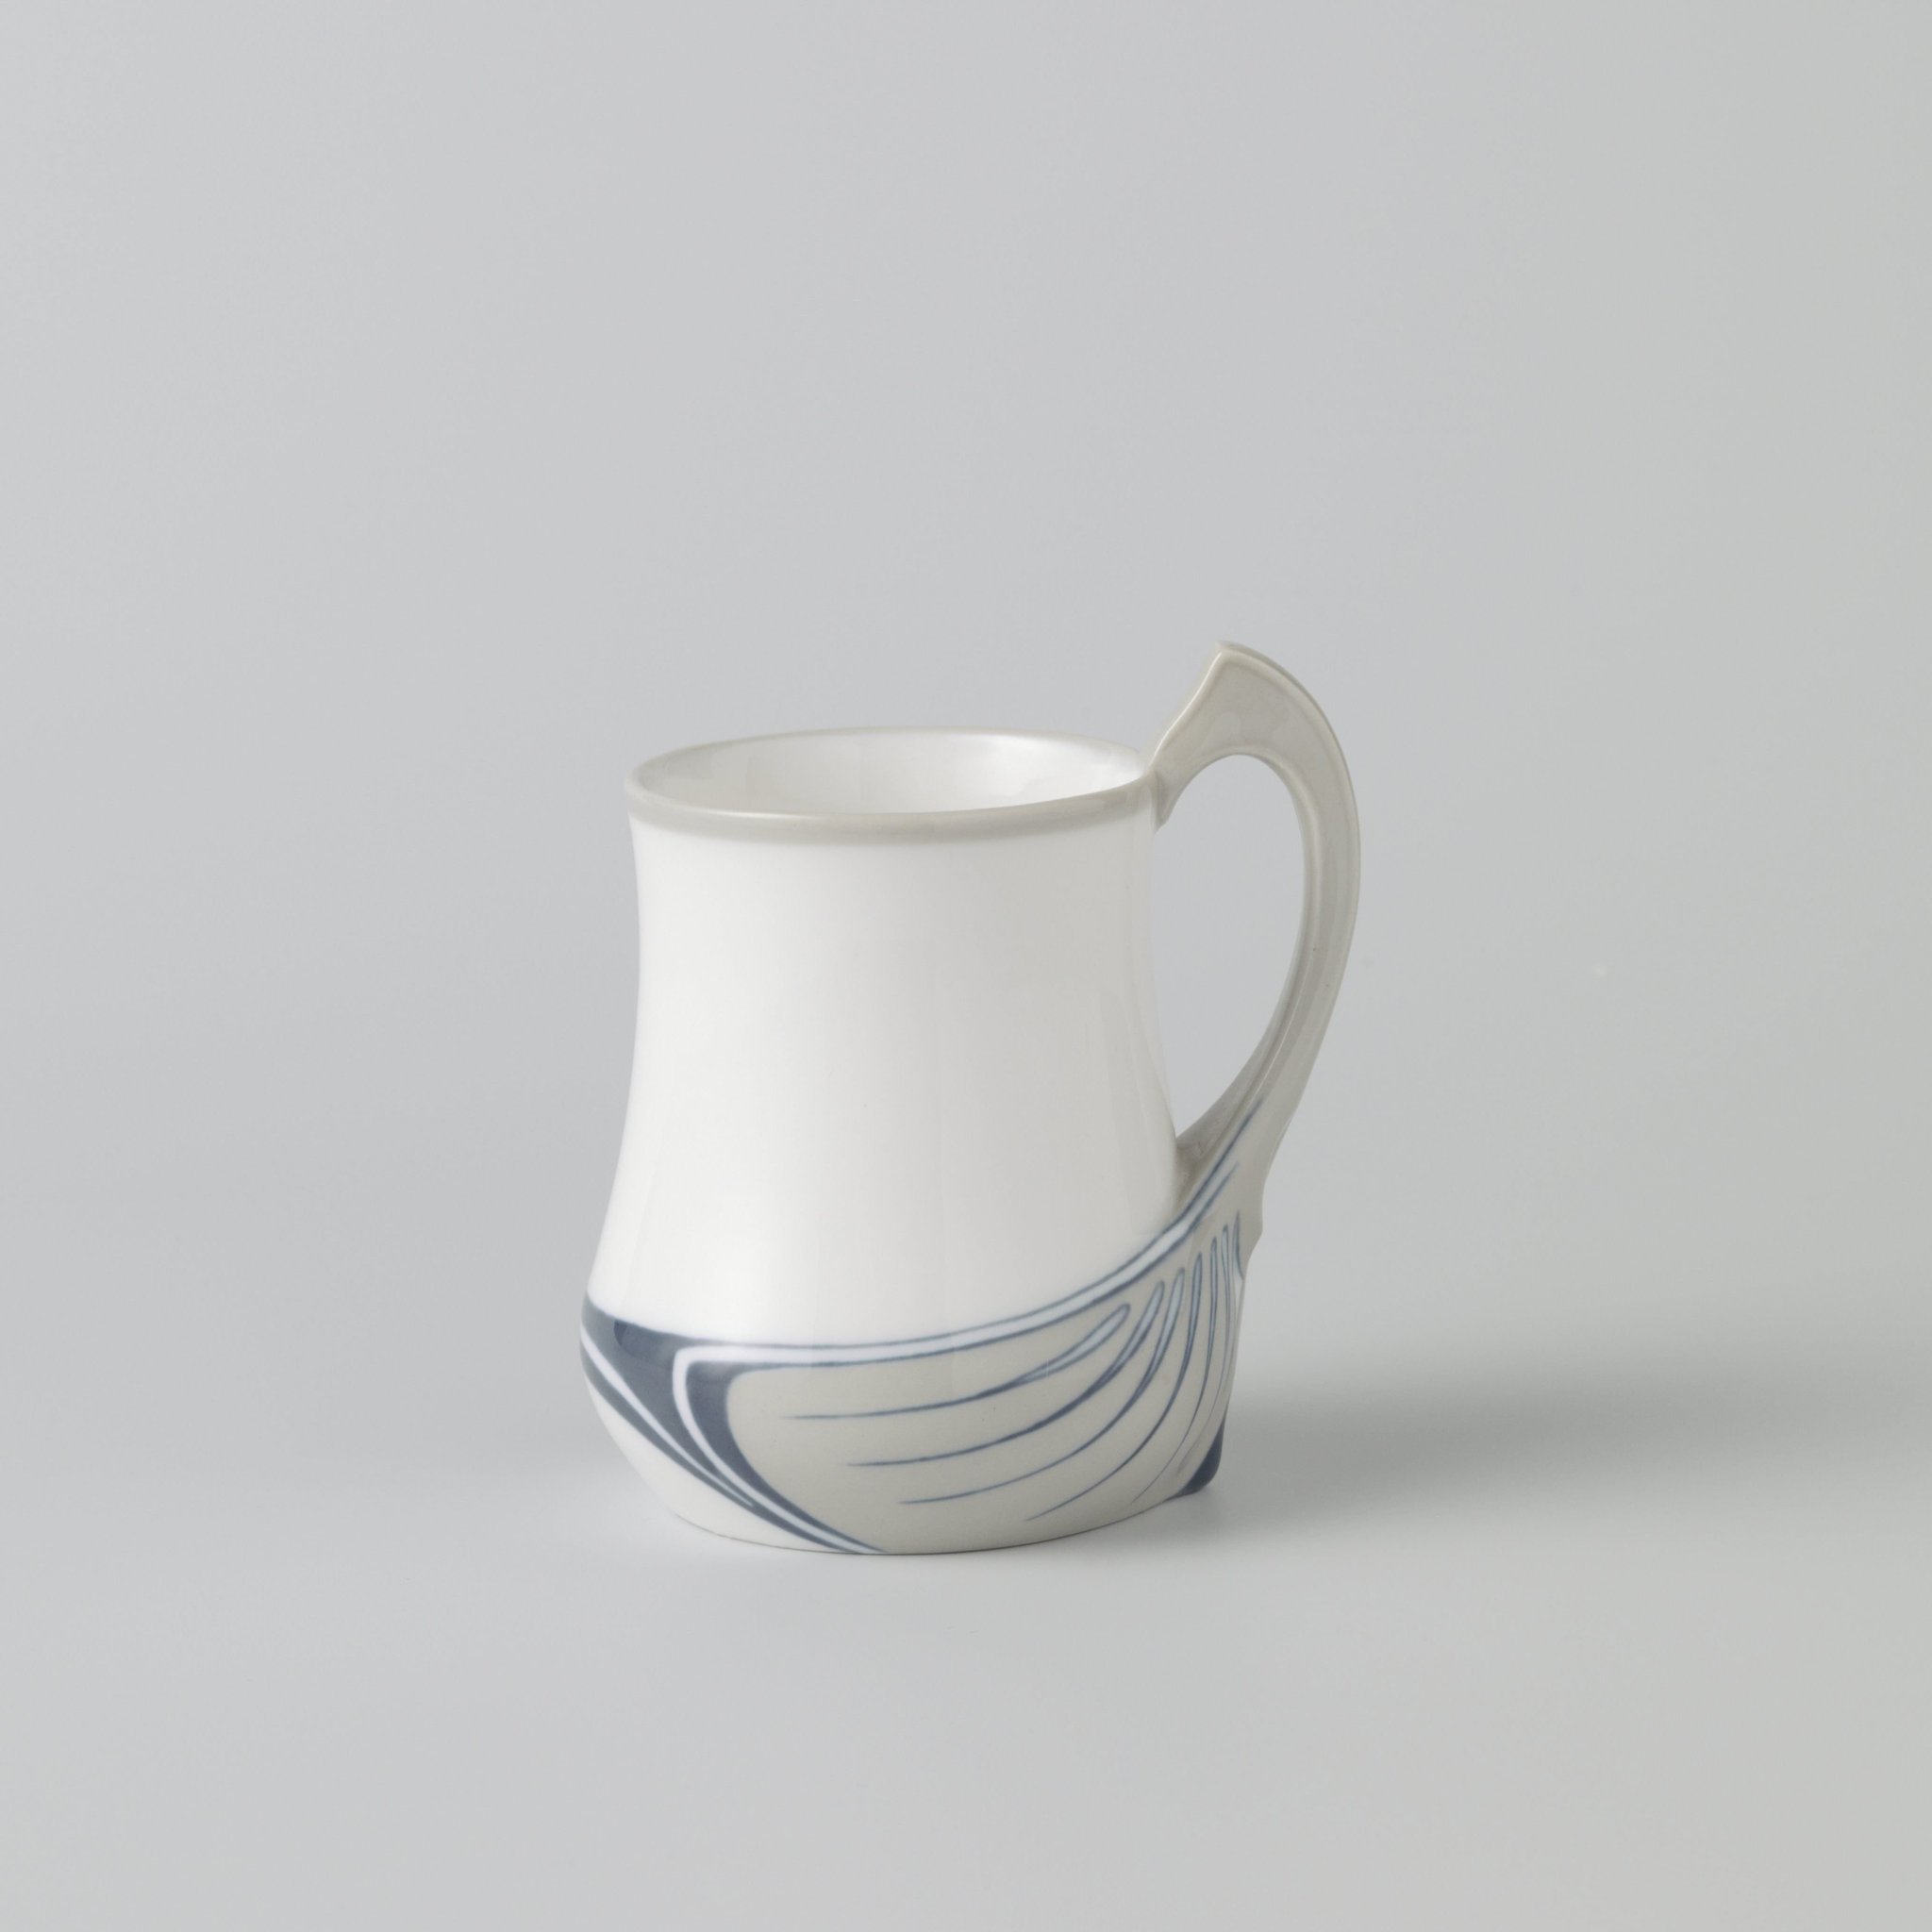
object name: eating drinking utensil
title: Kop uit het koffie- en theeservies 'Saxonia'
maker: otto eduard voigt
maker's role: keramiekontwerper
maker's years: 1870-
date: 1904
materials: porcelain, chemical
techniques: painted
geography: meissen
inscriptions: model number: ‘12’, factory mark, model number: ‘U 127’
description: Kop van porselein, beschilderd in blauw en grijs. De kop hoort bij het koffie- en theeservies Saxonia. De kop is gemerkt.